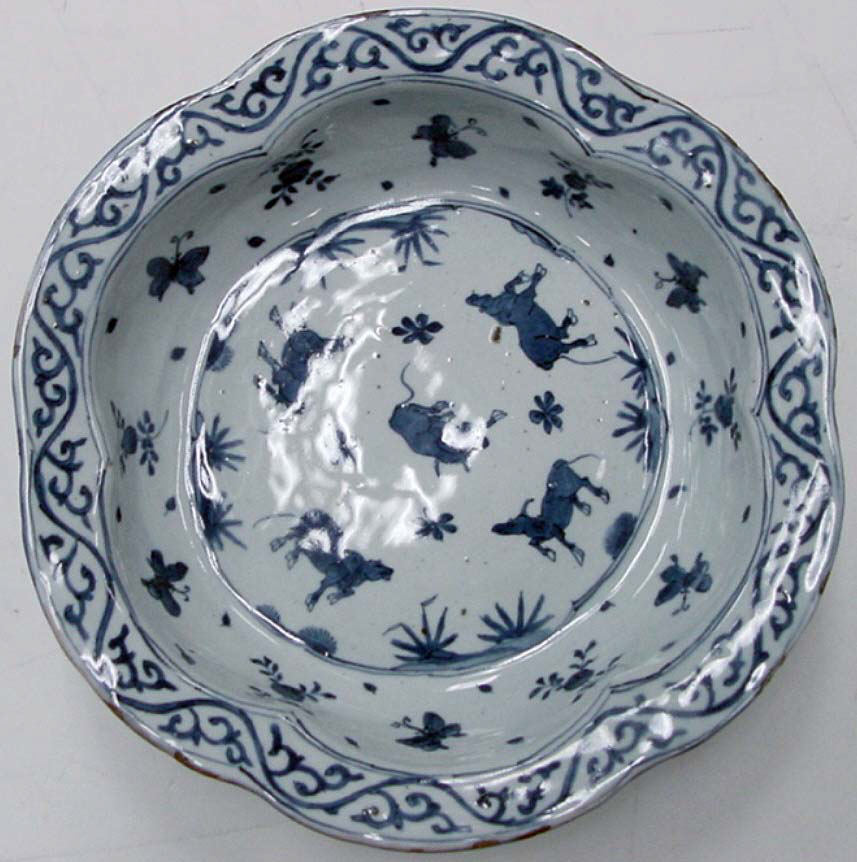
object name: dish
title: Dish with Decoration of Oxen and Cherry Blossoms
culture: chinese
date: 1620-1630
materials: cobalt, porcelain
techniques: painting, underglaze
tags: animals,butterflies,flowers